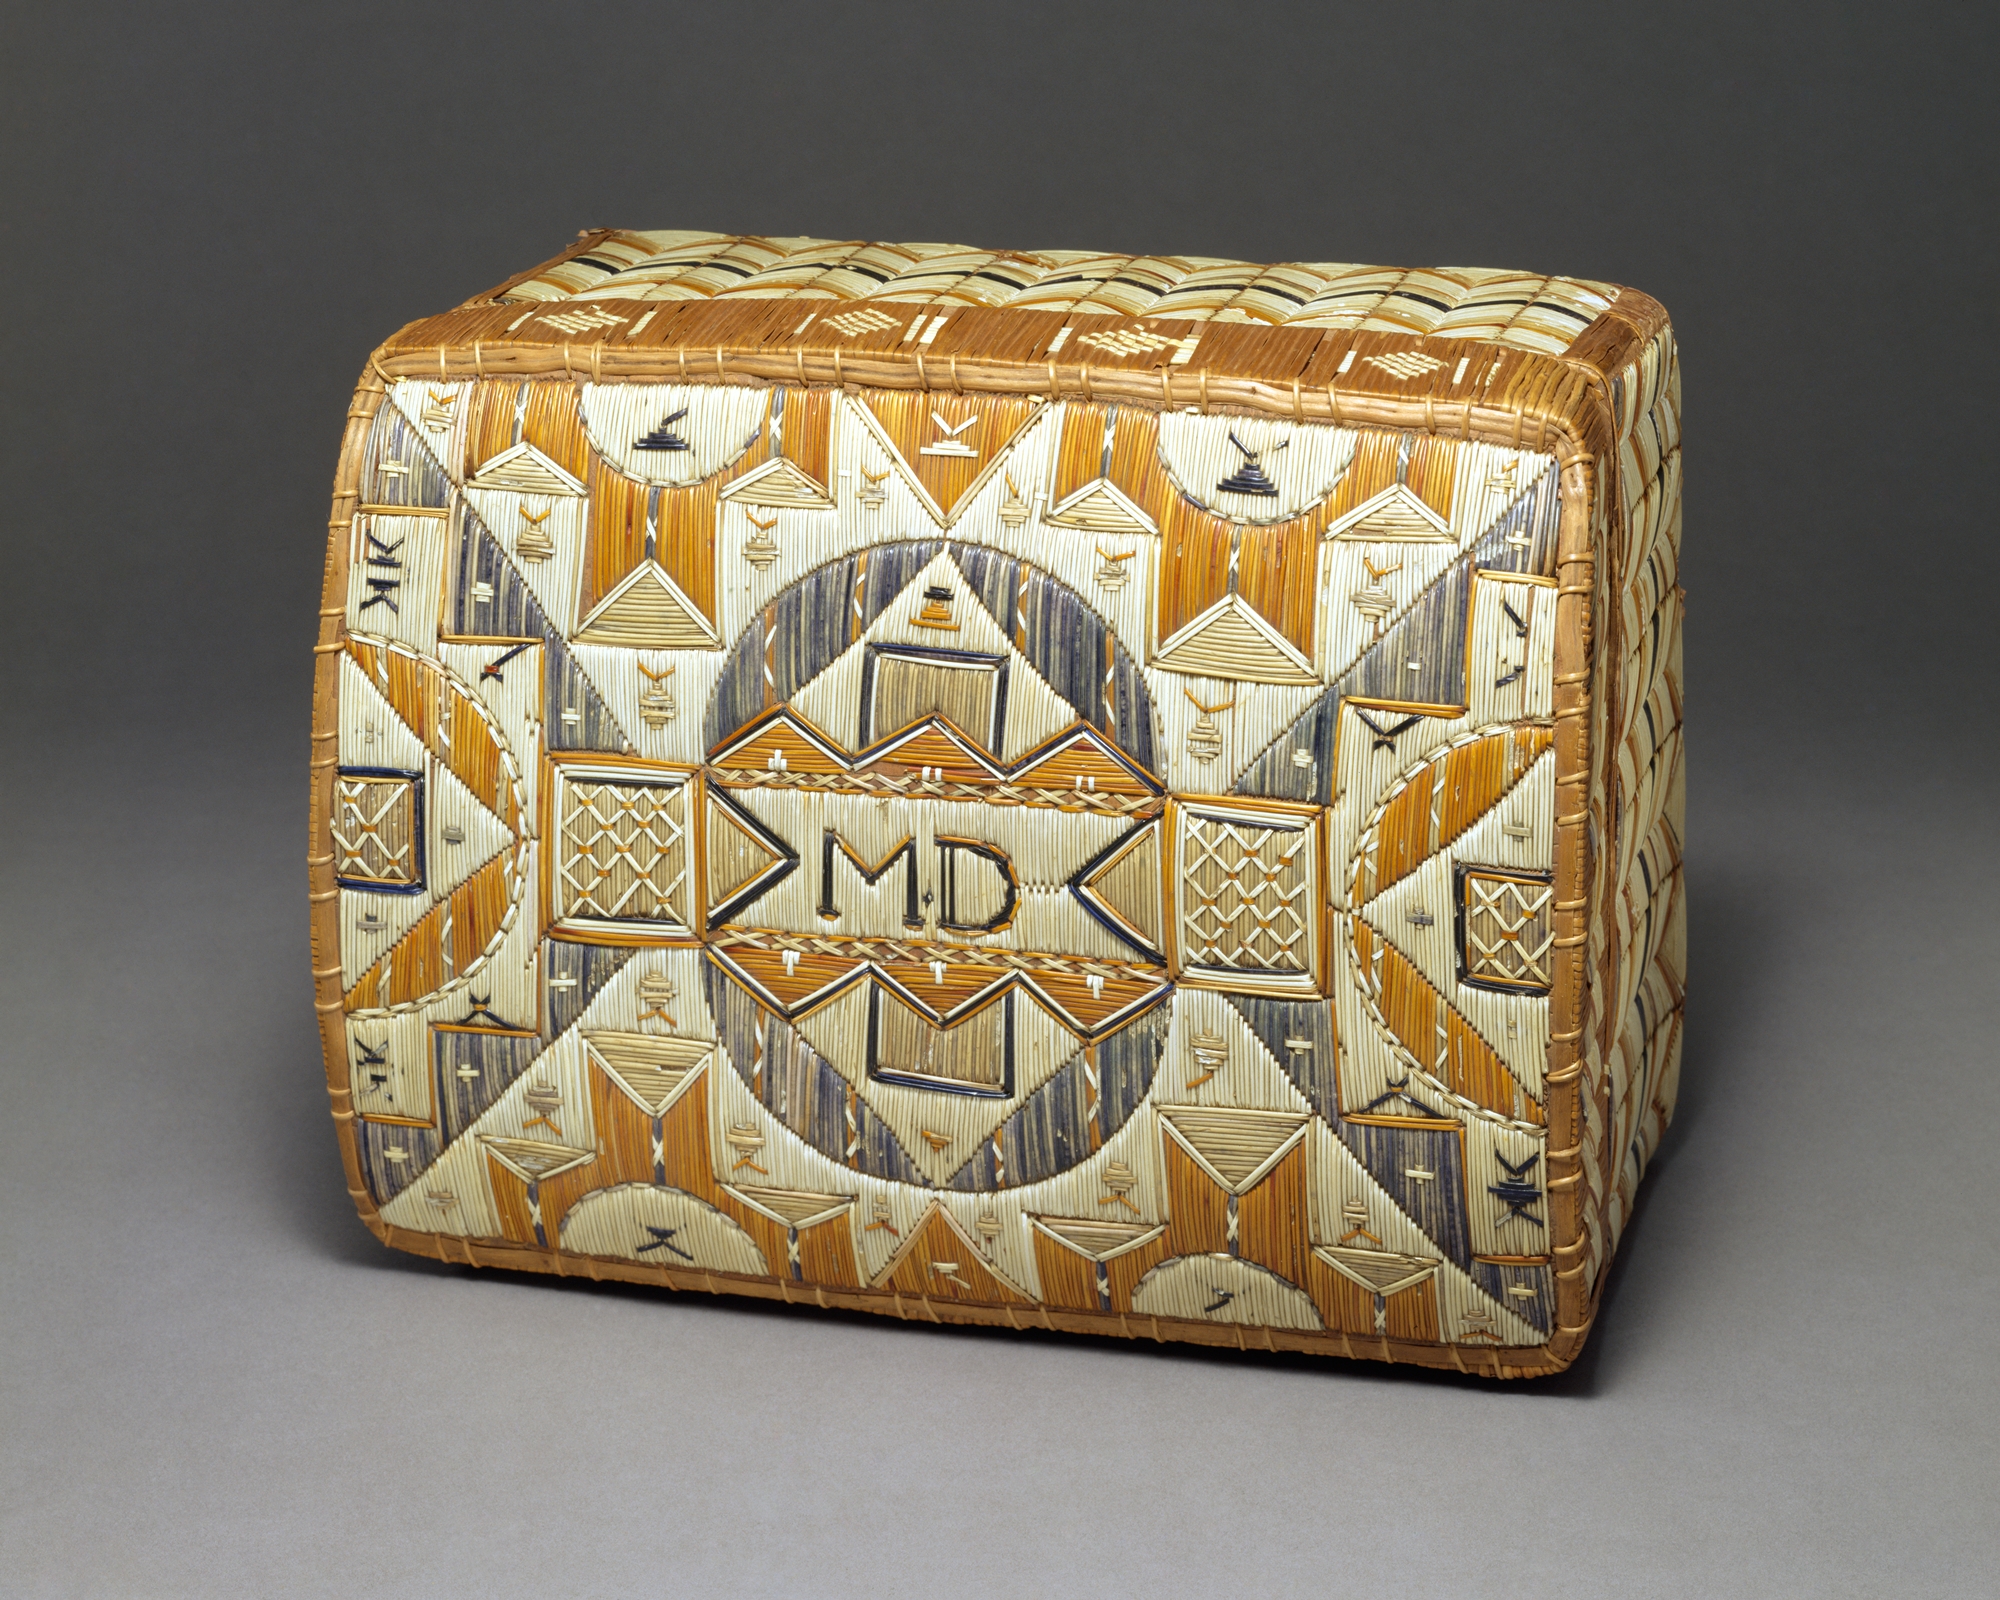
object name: trunk with lid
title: Lidded Trunk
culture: micmac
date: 1840-1850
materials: wood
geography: canada